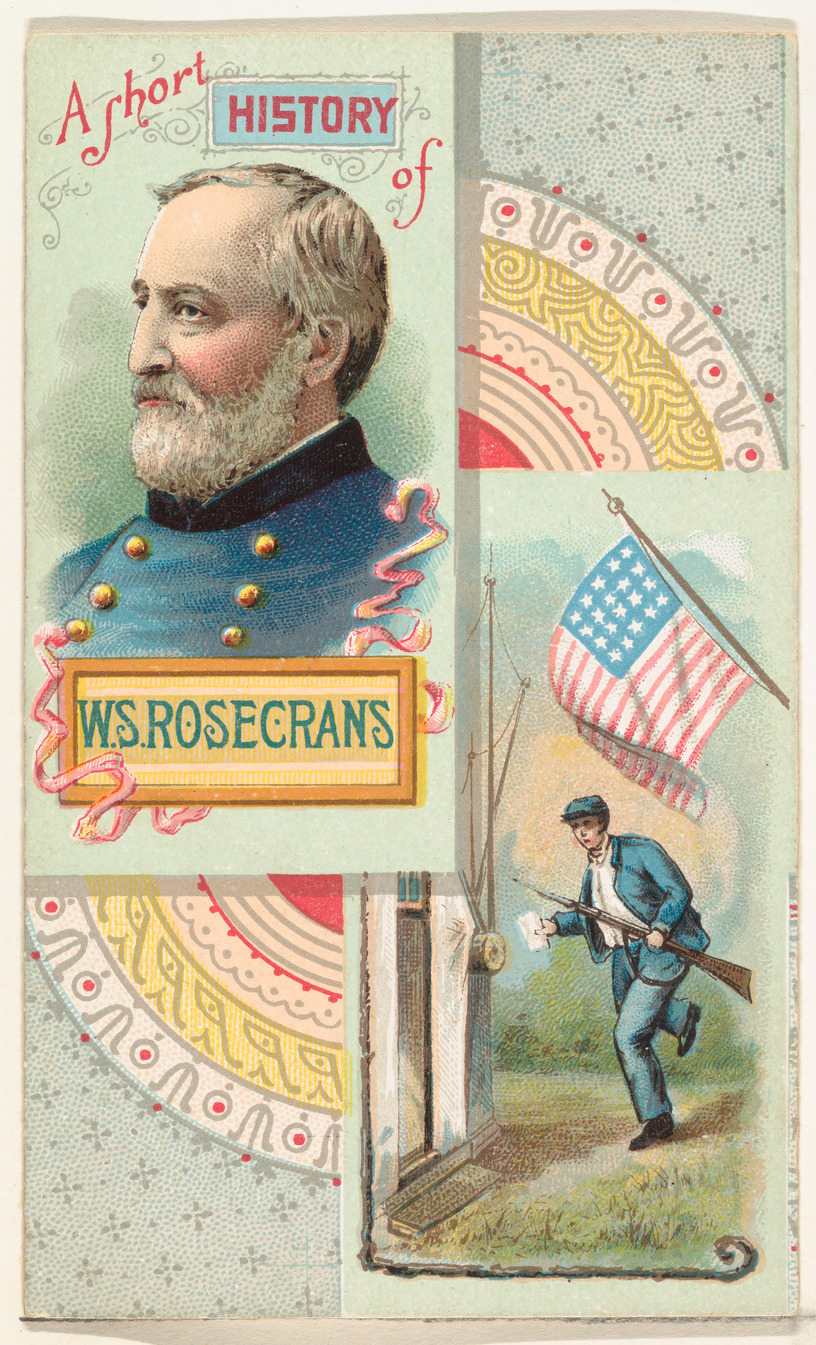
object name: print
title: A Short History: General William S. Rosecrans, from the Histories of Generals series (N114) issued by W. Duke, Sons & Co. to promote Honest Long Cut Smoking and Chewing Tobacco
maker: w. duke, sons & co.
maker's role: publisher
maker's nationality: american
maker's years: 1870-1920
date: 1888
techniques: color lithograph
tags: firearms,men,profiles,flags